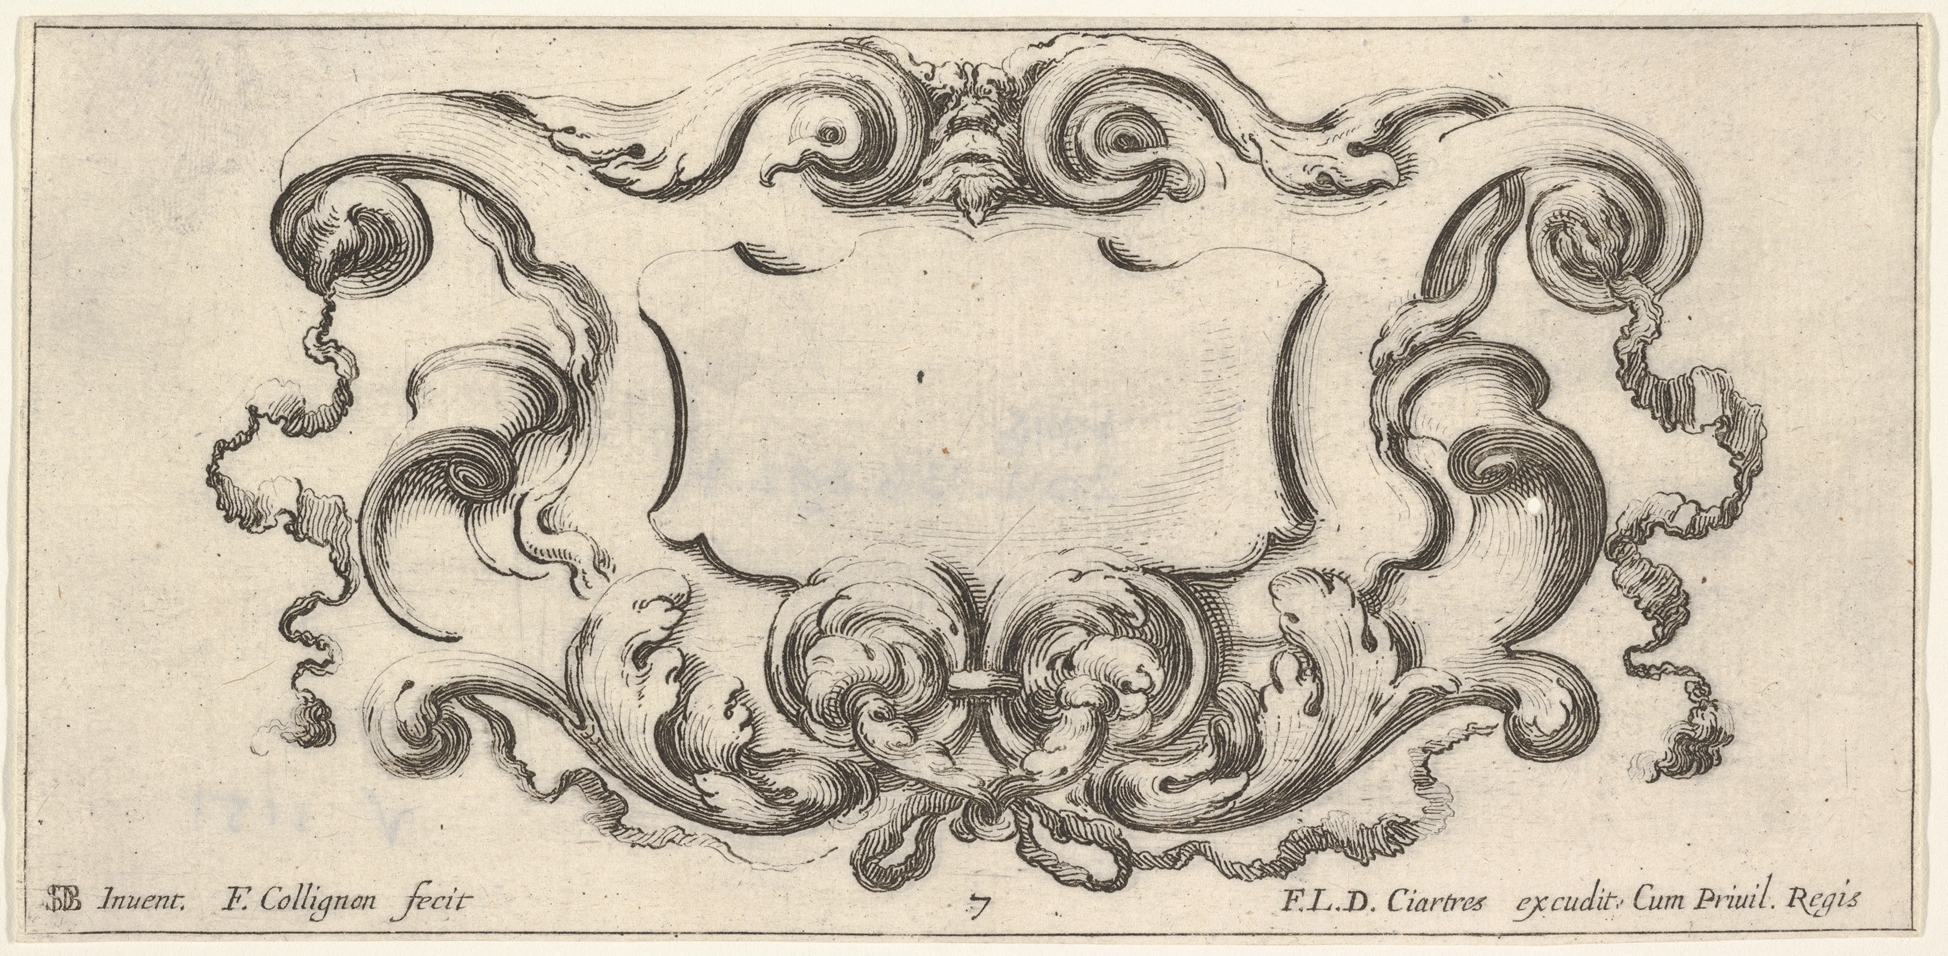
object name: print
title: Plate 7: a cartouche with the mask of an ogre at top center, scrollwork to either side, from "Twelve cartouches" (Recueil de douze cartouches)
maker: françois collignon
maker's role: artist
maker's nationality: french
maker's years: 1605-1687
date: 1640-1645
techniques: etching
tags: masks,cartouches